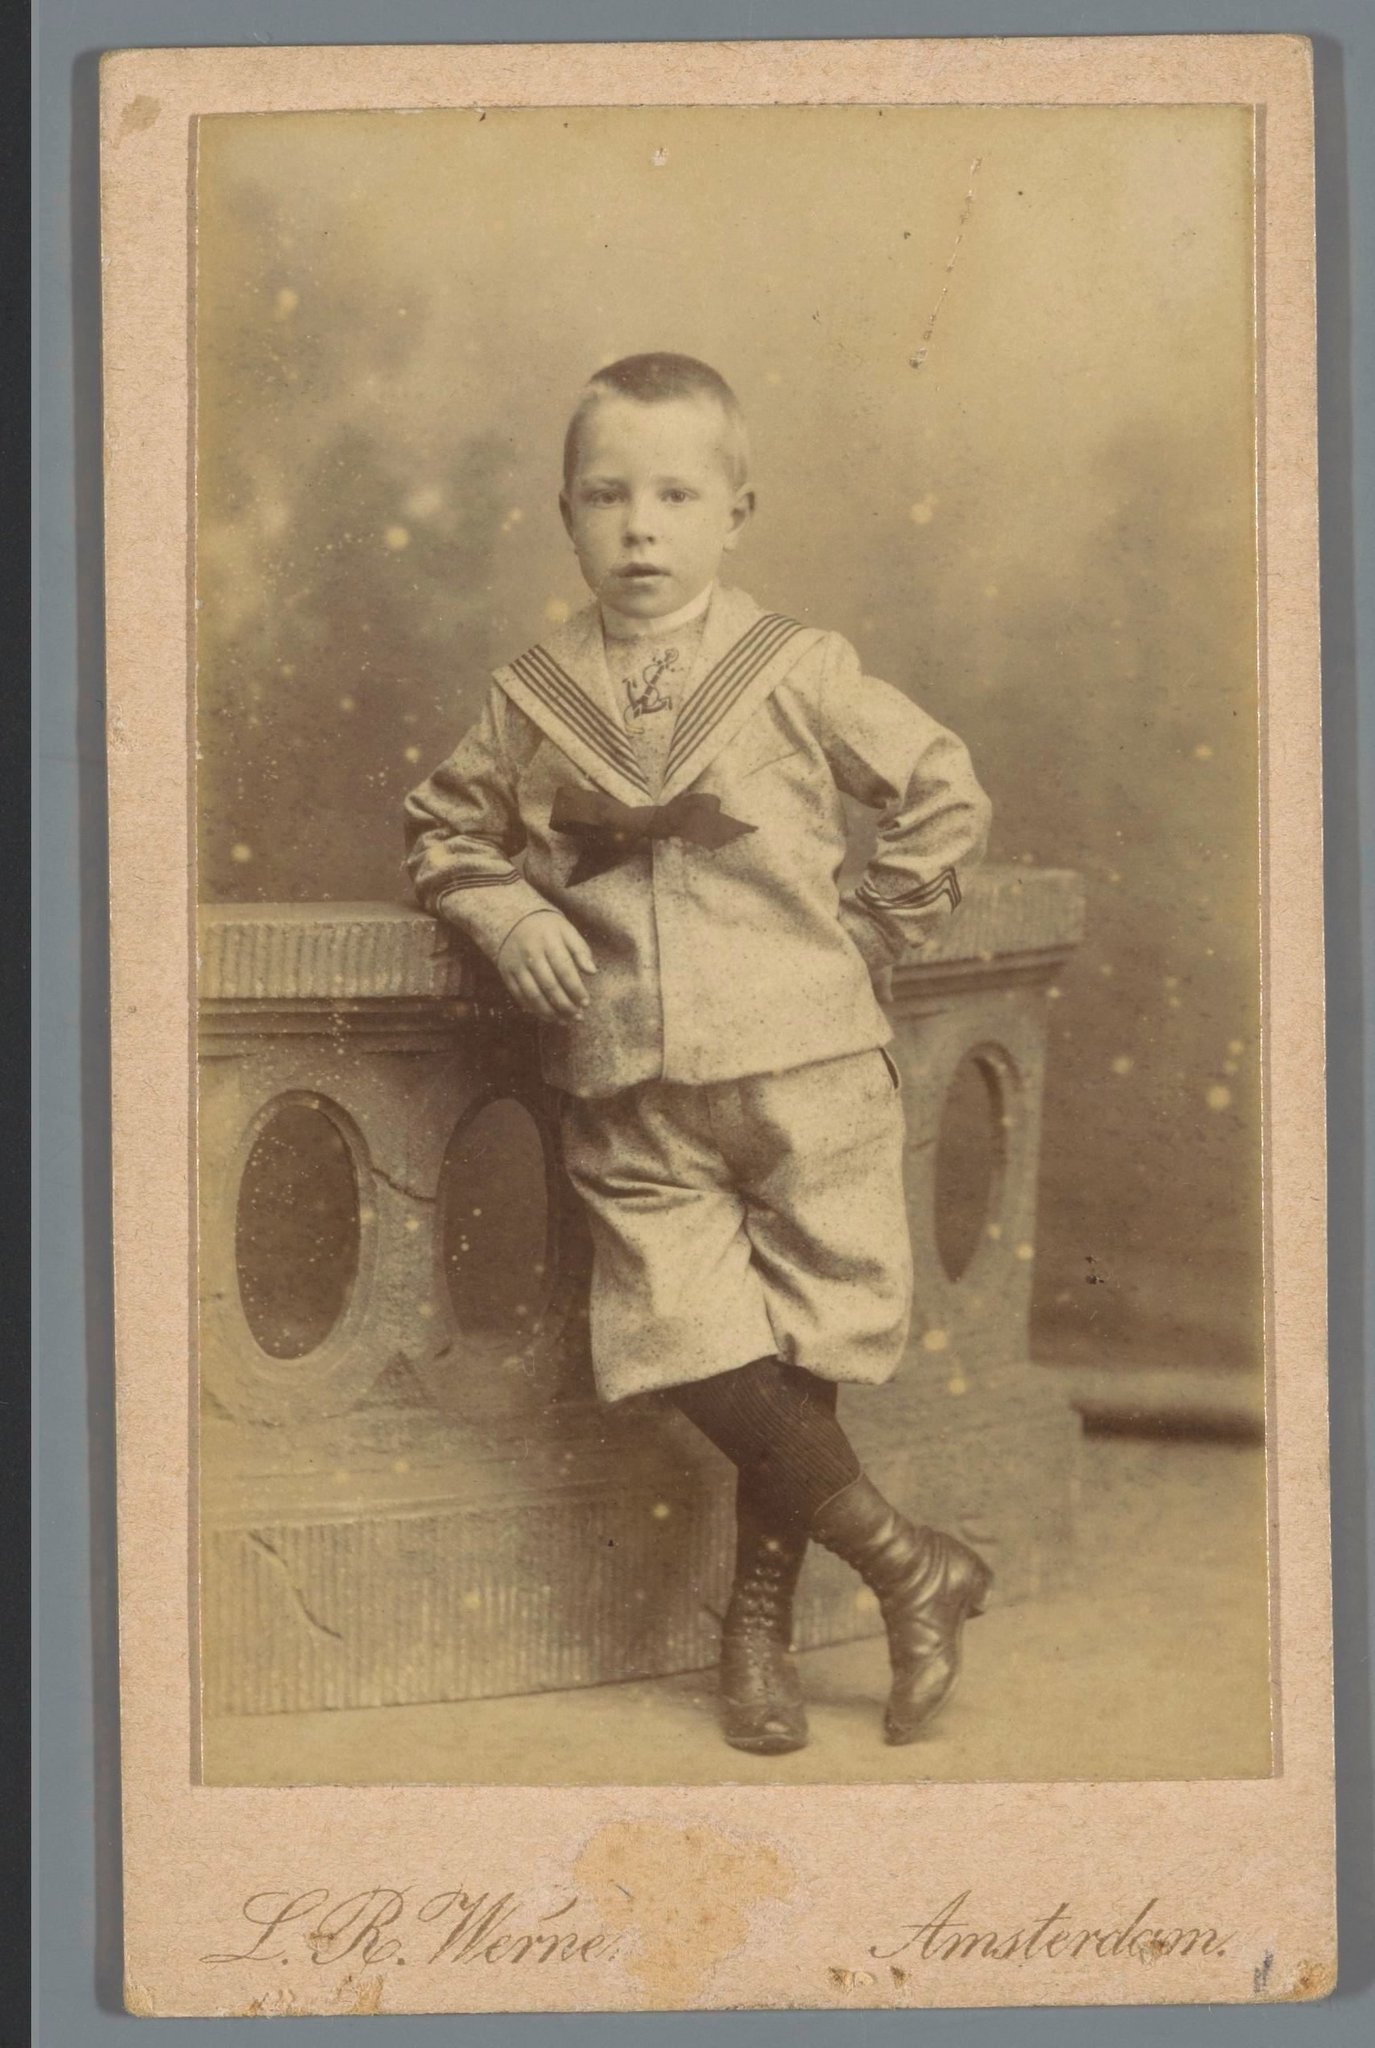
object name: carte de visite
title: Portret van een onbekende jongen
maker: louis robert werner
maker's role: fotograaf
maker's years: 1834-1896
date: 1878-1886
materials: cardboard, paper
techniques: albumen print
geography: amsterdam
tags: boy (child between toddler and youth), anonymous historical person portrayed, amsterdam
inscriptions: inscription: ‘L.R. Werner Amsterdam.’, inscription: ‘H. Jan Fl[...]’, inscription: ‘L.R. Werner/ voorheen P. Carstensen/ Amsterdam/ Nieuwendijk H.150./ Nabestellingen en Vergrotingen,/ ook van andere Portretten, kunnen iederen tijd geleverd worden./ Ferd. Beyrich, Berlin’